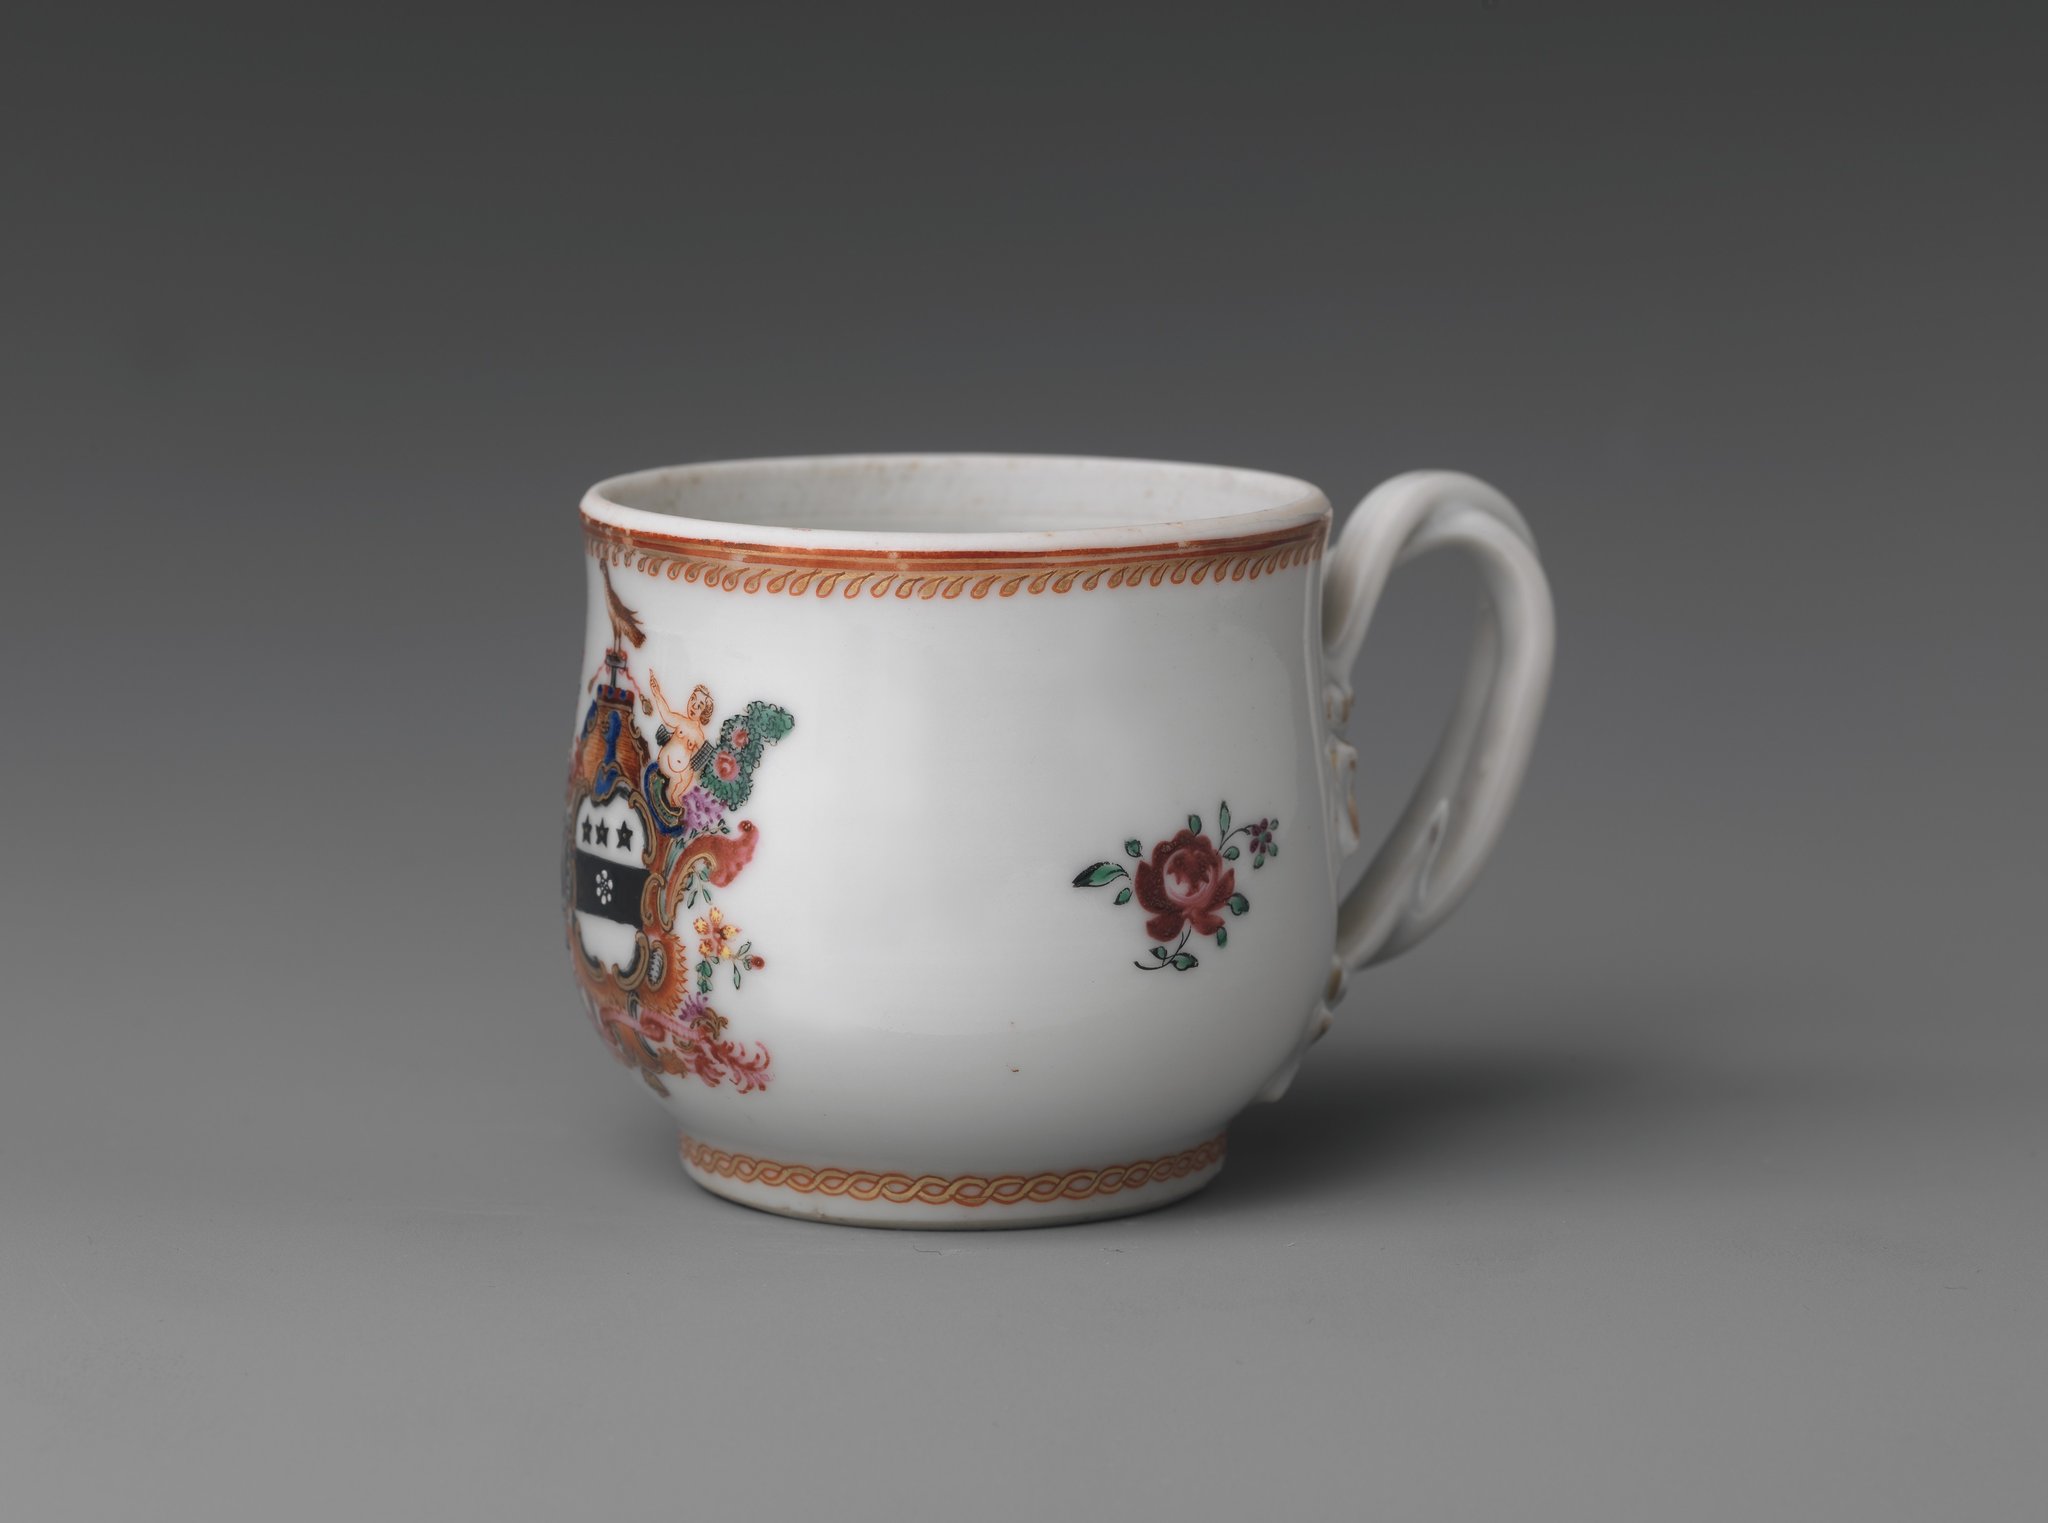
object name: custard cup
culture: chinese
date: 1785-1790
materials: porcelain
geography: china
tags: flowers,coat of arms